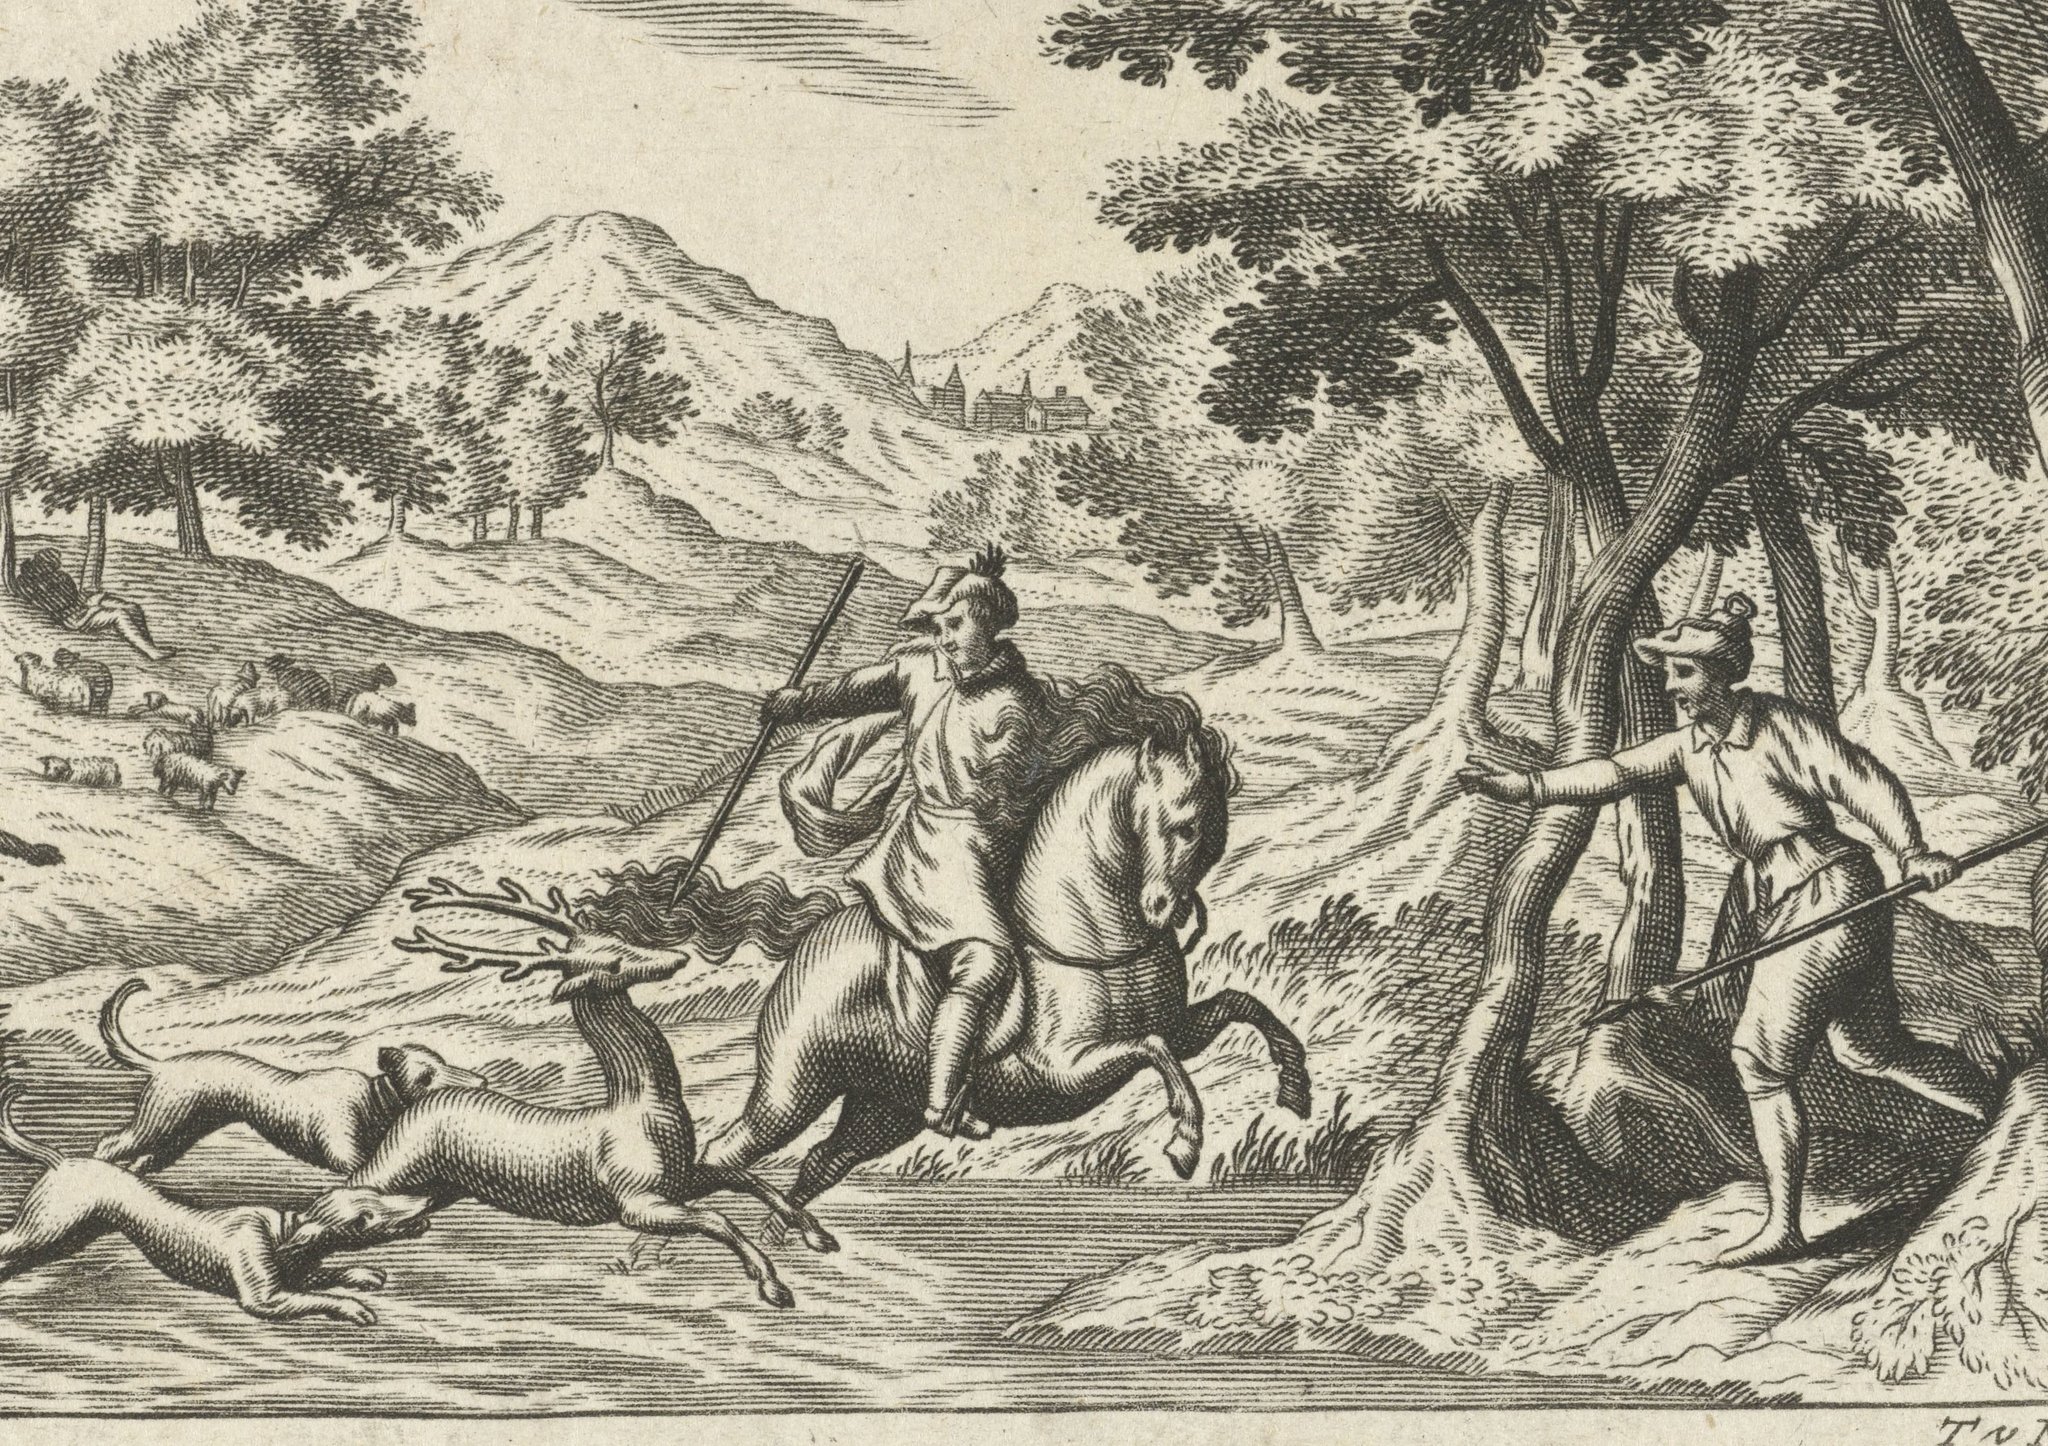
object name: print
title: Hertenjacht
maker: theodor van merlen (ii)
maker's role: print maker, publisher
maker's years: 1609-1672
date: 1619-1672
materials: paper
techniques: engraving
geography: antwerp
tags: stag-hunting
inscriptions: collector's mark: Lugt 2228